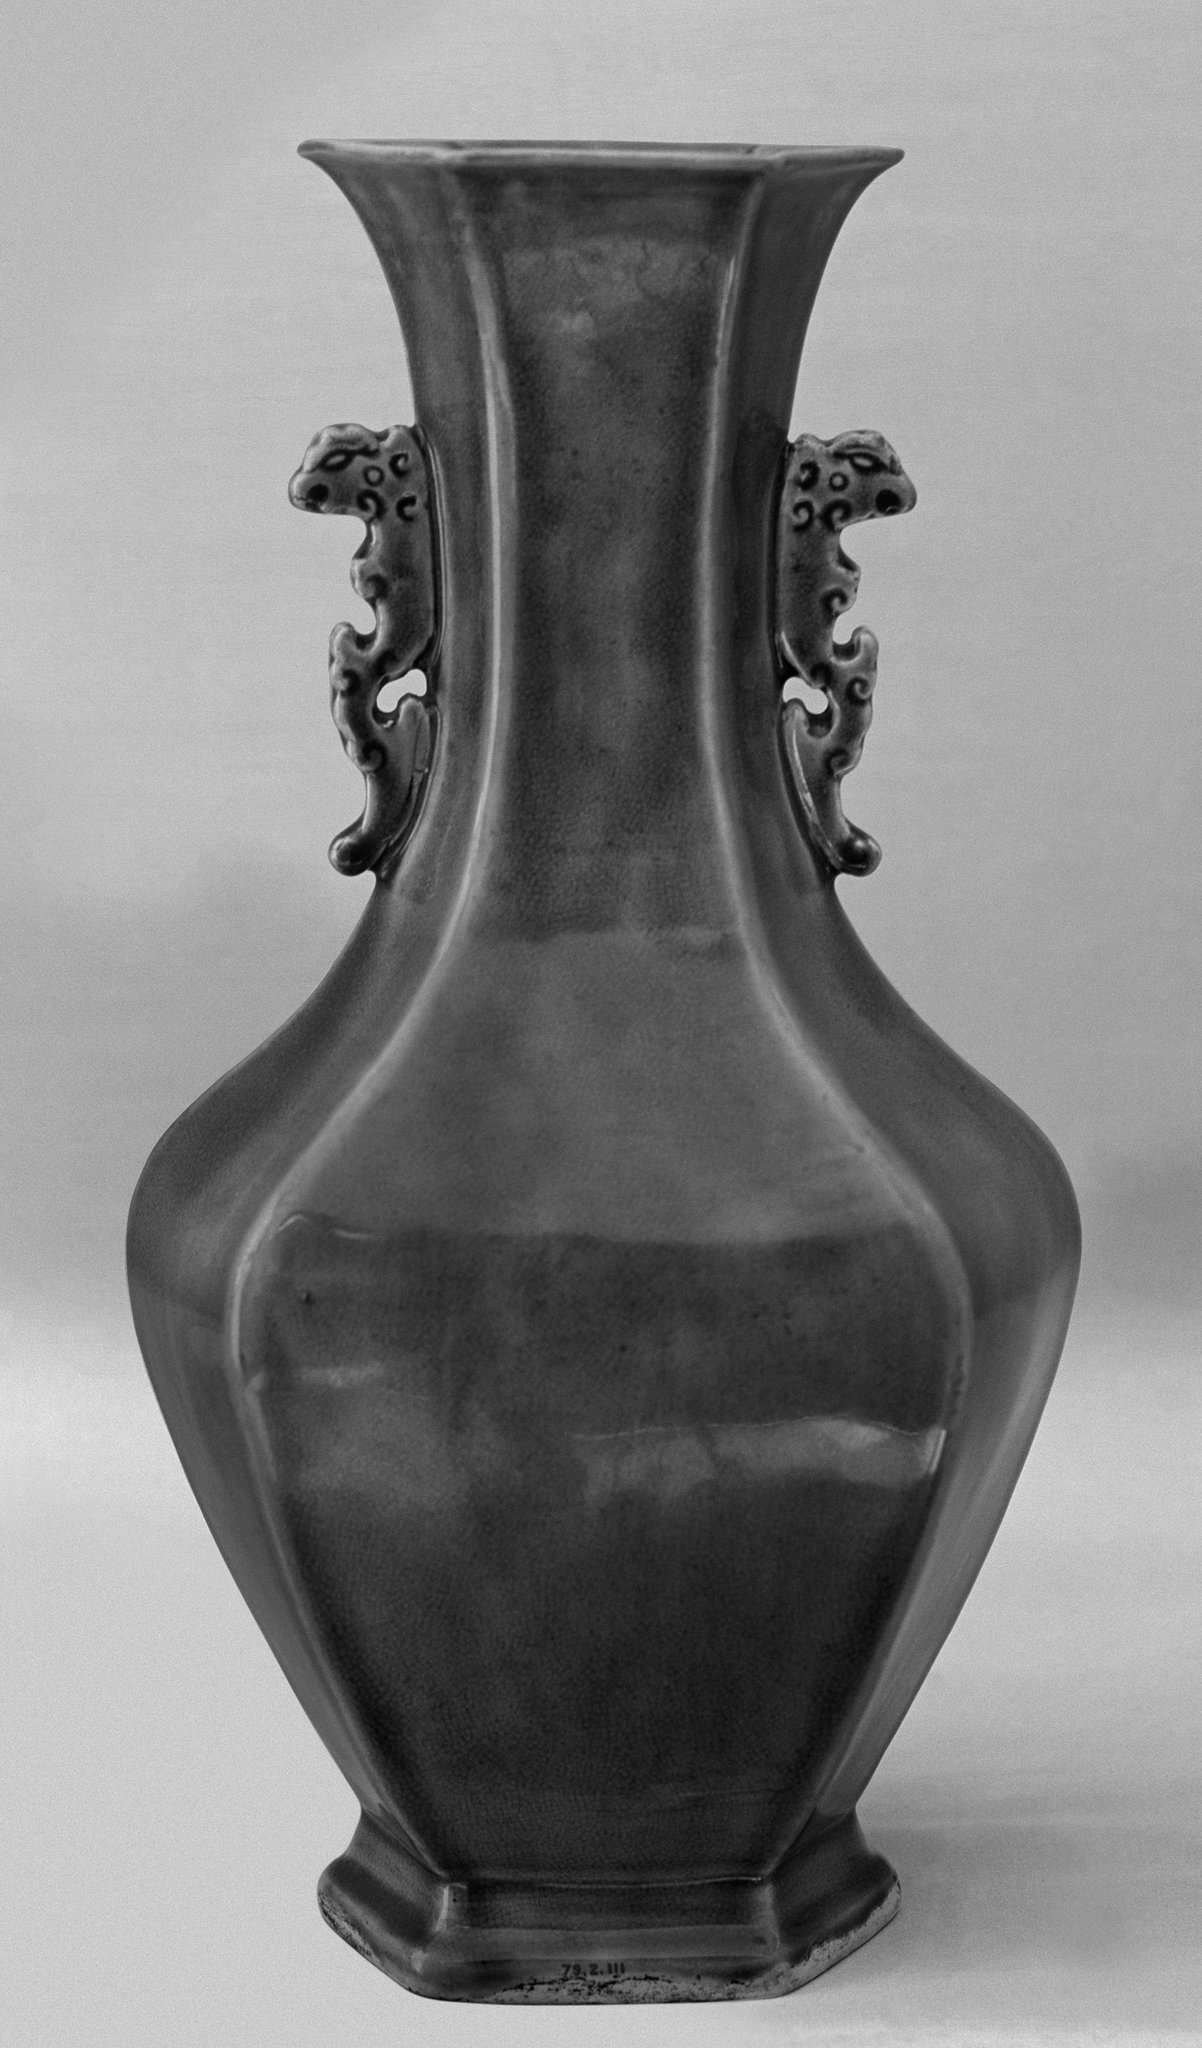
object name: vase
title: Hexagonal vase with stylized phoenix handles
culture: chinese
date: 1734-1766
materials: glaze, porcelain